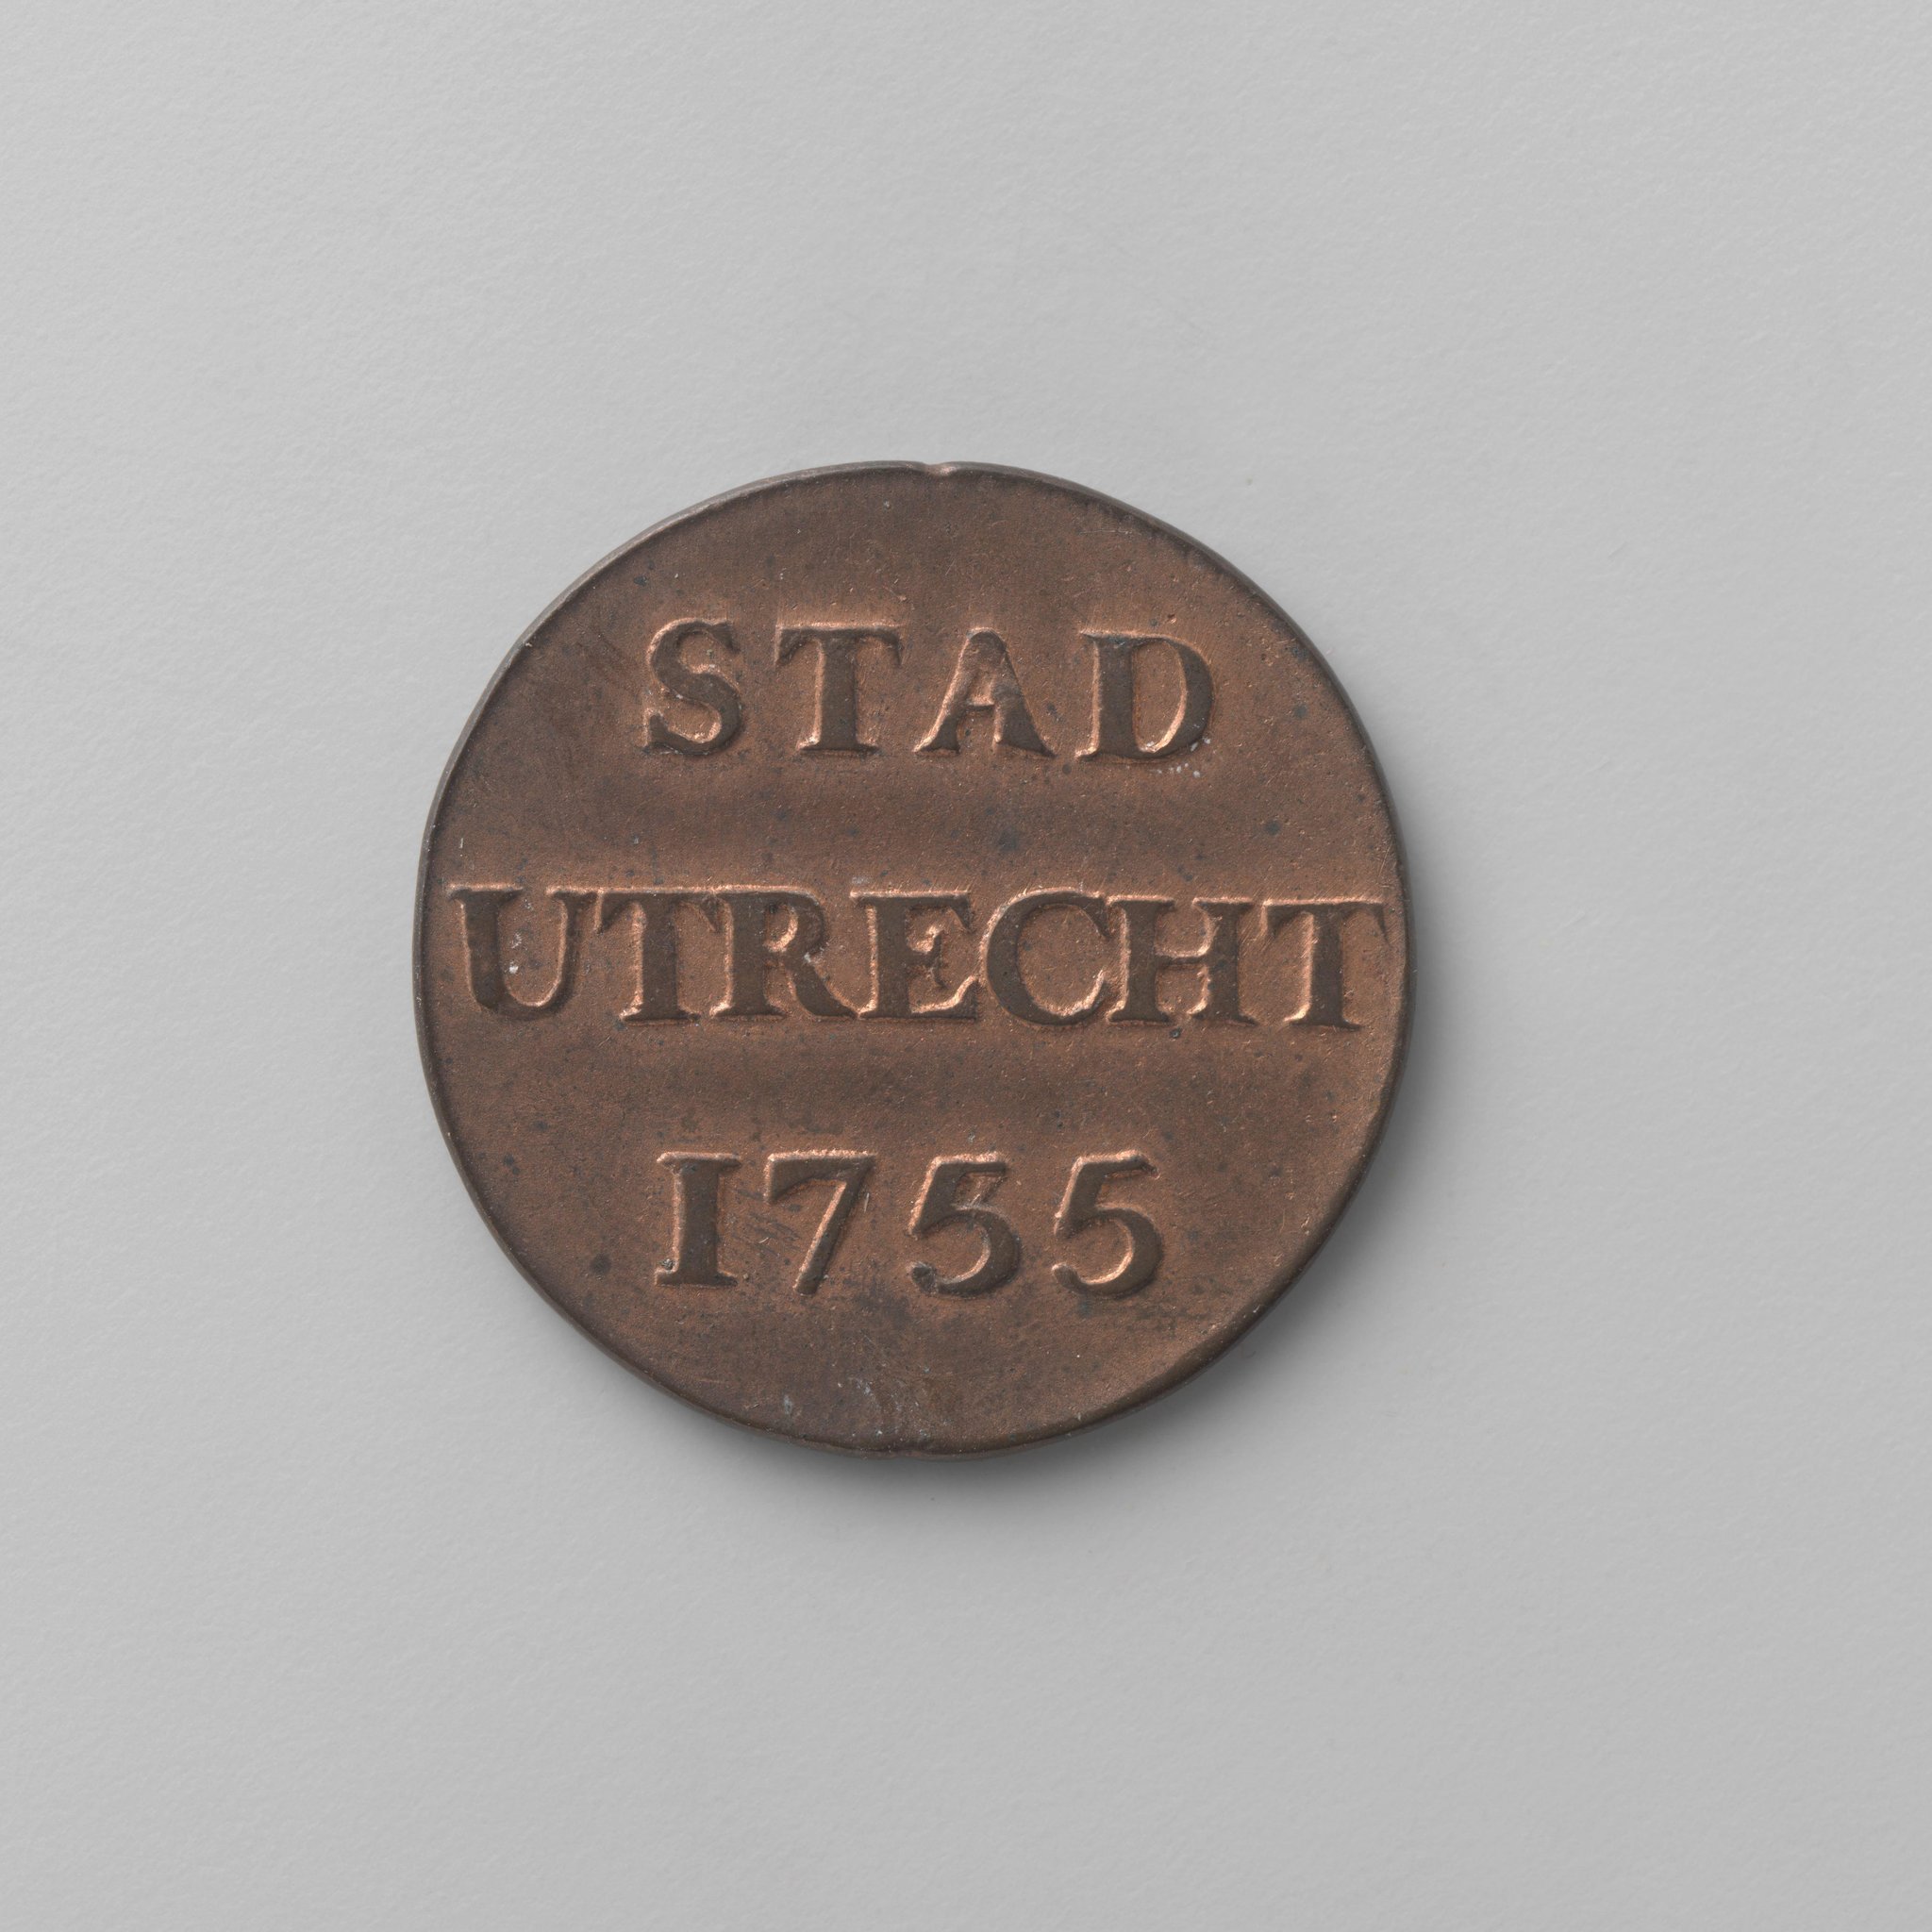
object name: coin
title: Stad Utrecht, duit, 1755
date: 1755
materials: copper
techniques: striking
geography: utrecht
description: Koperen munt. Voorzijde: gekroond stedelijk wapenschild, gehouden door twee leeuwen met in afsnede dunne lijn, waaronder een versierde accolade met een grote schelp. Keerzijde: opschrift in twee regels, waaronder jaartal. Jaartal met Romeinse I.